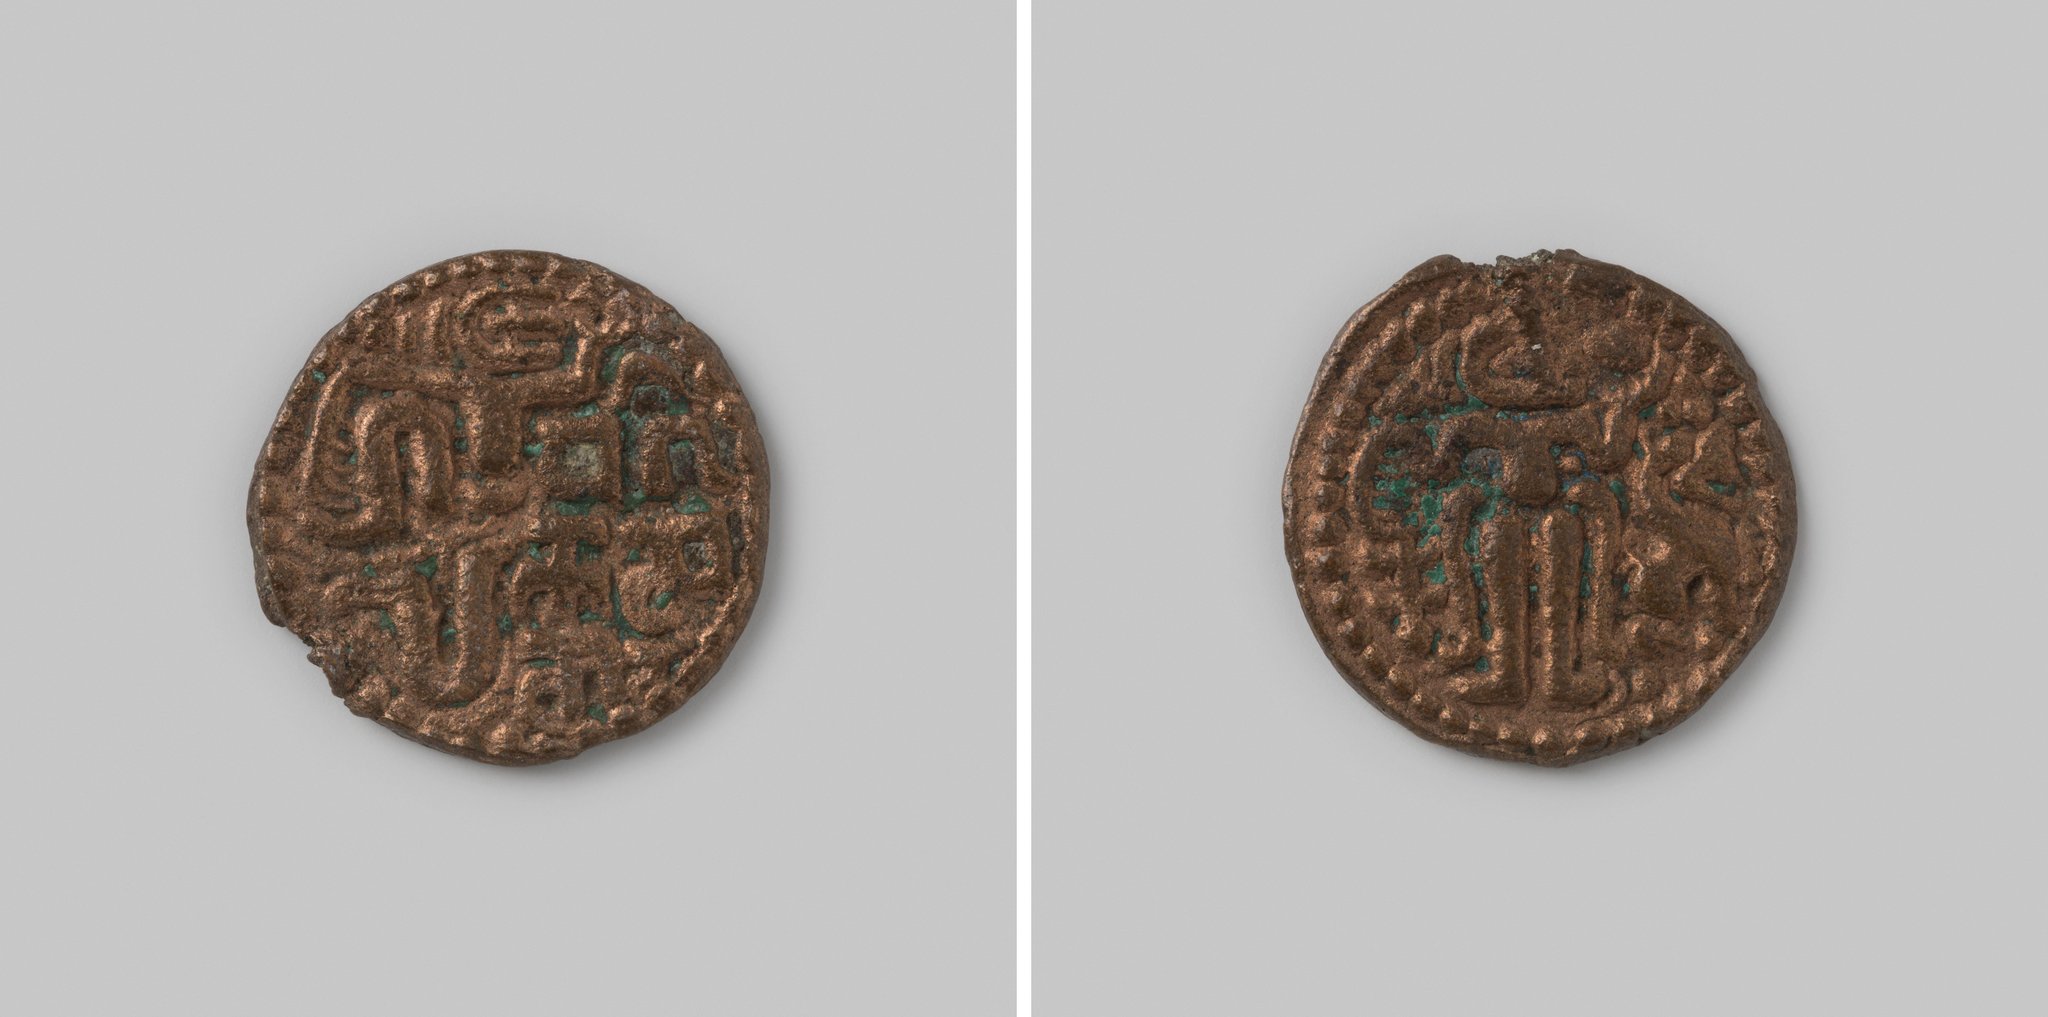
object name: coin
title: Kahavanu uit Sri Lanka, Ceylon van Parakrama Bahu III, 1302-1310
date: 1302-1310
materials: copper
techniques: striking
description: Koperen munt. Voorzijde: zittende figuur, waaromheen in vier regels opschrift in Nagari-tekens: Sri/Para/krama/Bahu. Keerzijde: staande figuur met rechts van hem zittende leeuw en elders andere symbolen.